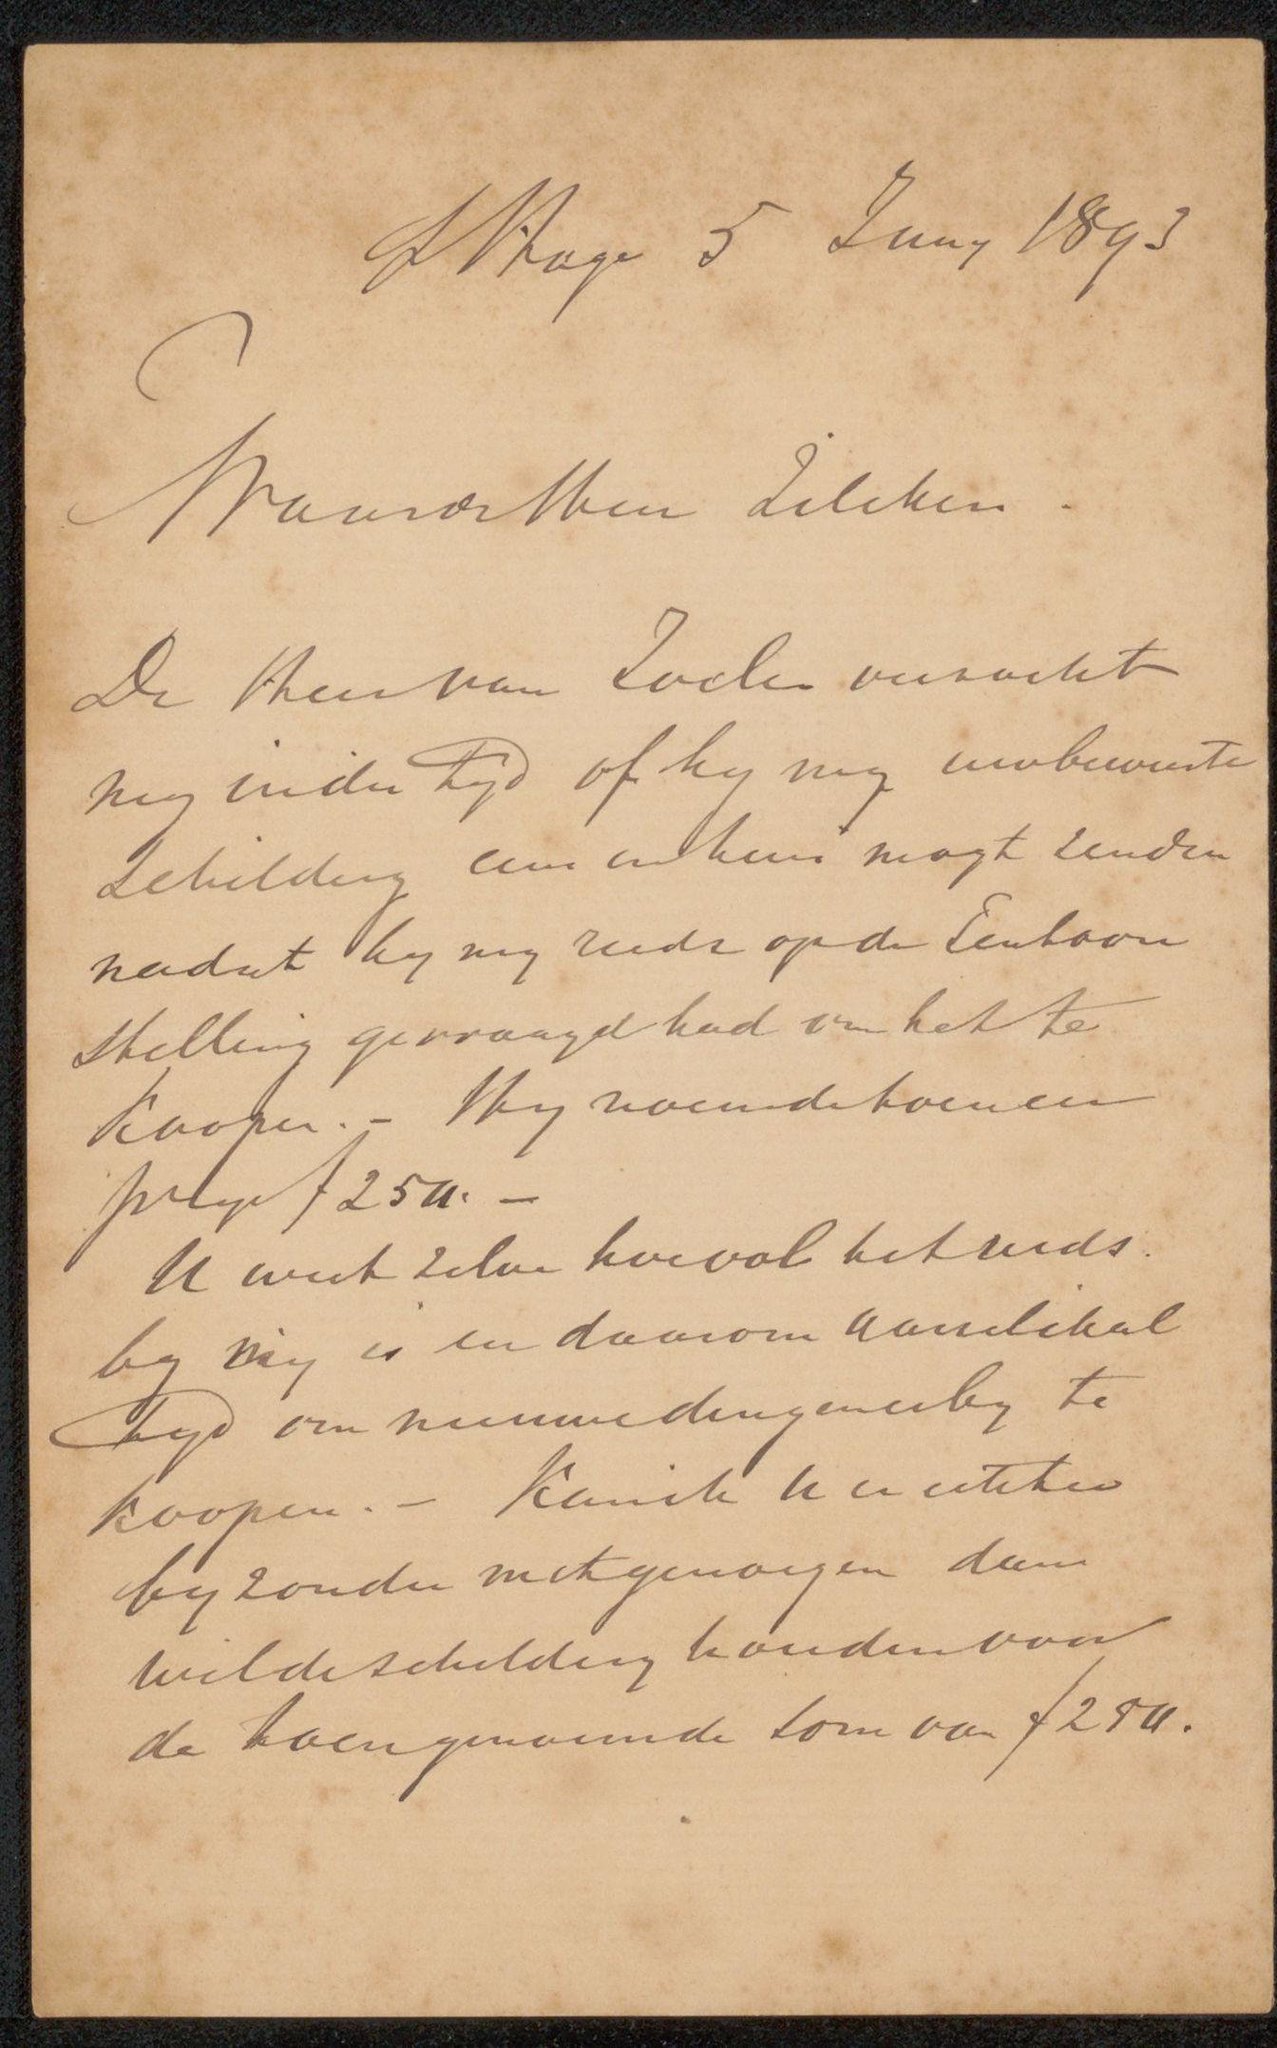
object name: letter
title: Brief aan Philip Zilcken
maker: hendrik willem mesdag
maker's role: draughtsman, painter, print maker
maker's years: 1831-1915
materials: ink, paper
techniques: pen, writing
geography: the hague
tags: philip zilcken, painting (including book-illumination, miniature-painting), art collecting, money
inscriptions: watermark